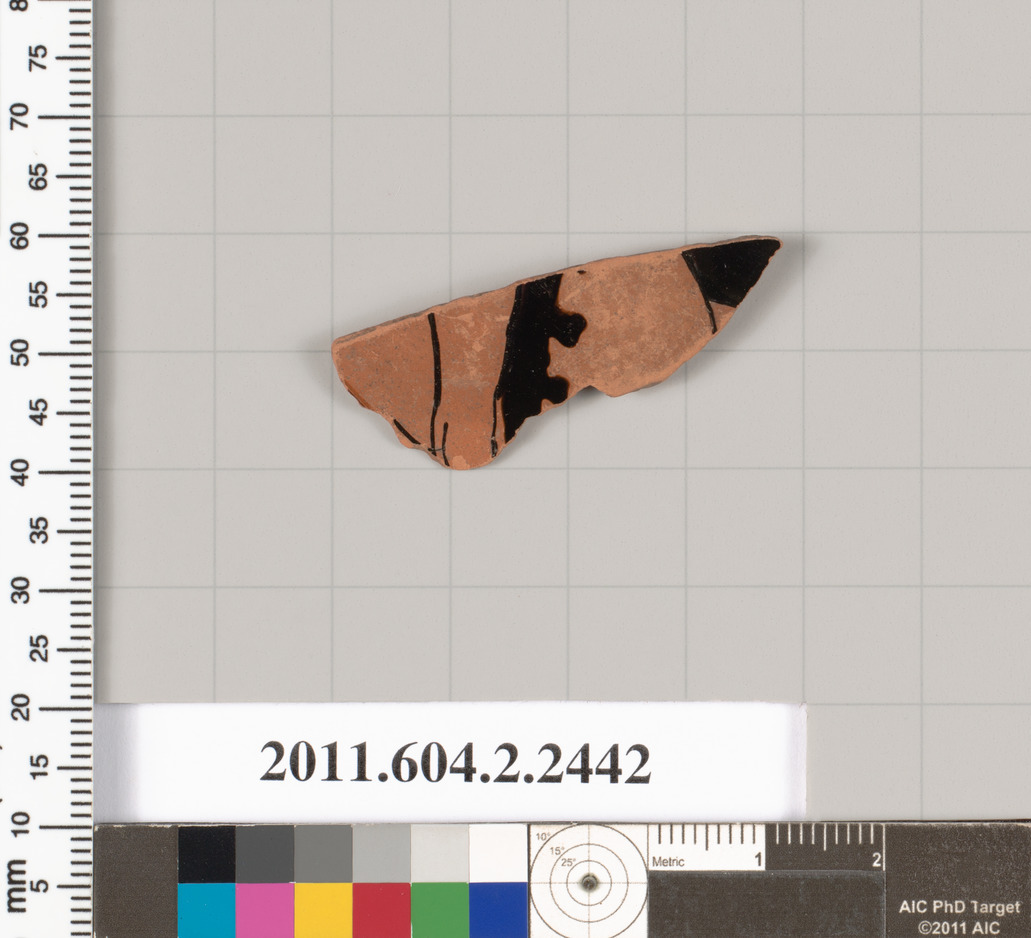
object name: undetermined shape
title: Terracotta fragment of an undetermined shape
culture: greek, attic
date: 500-476 BCE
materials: terracotta